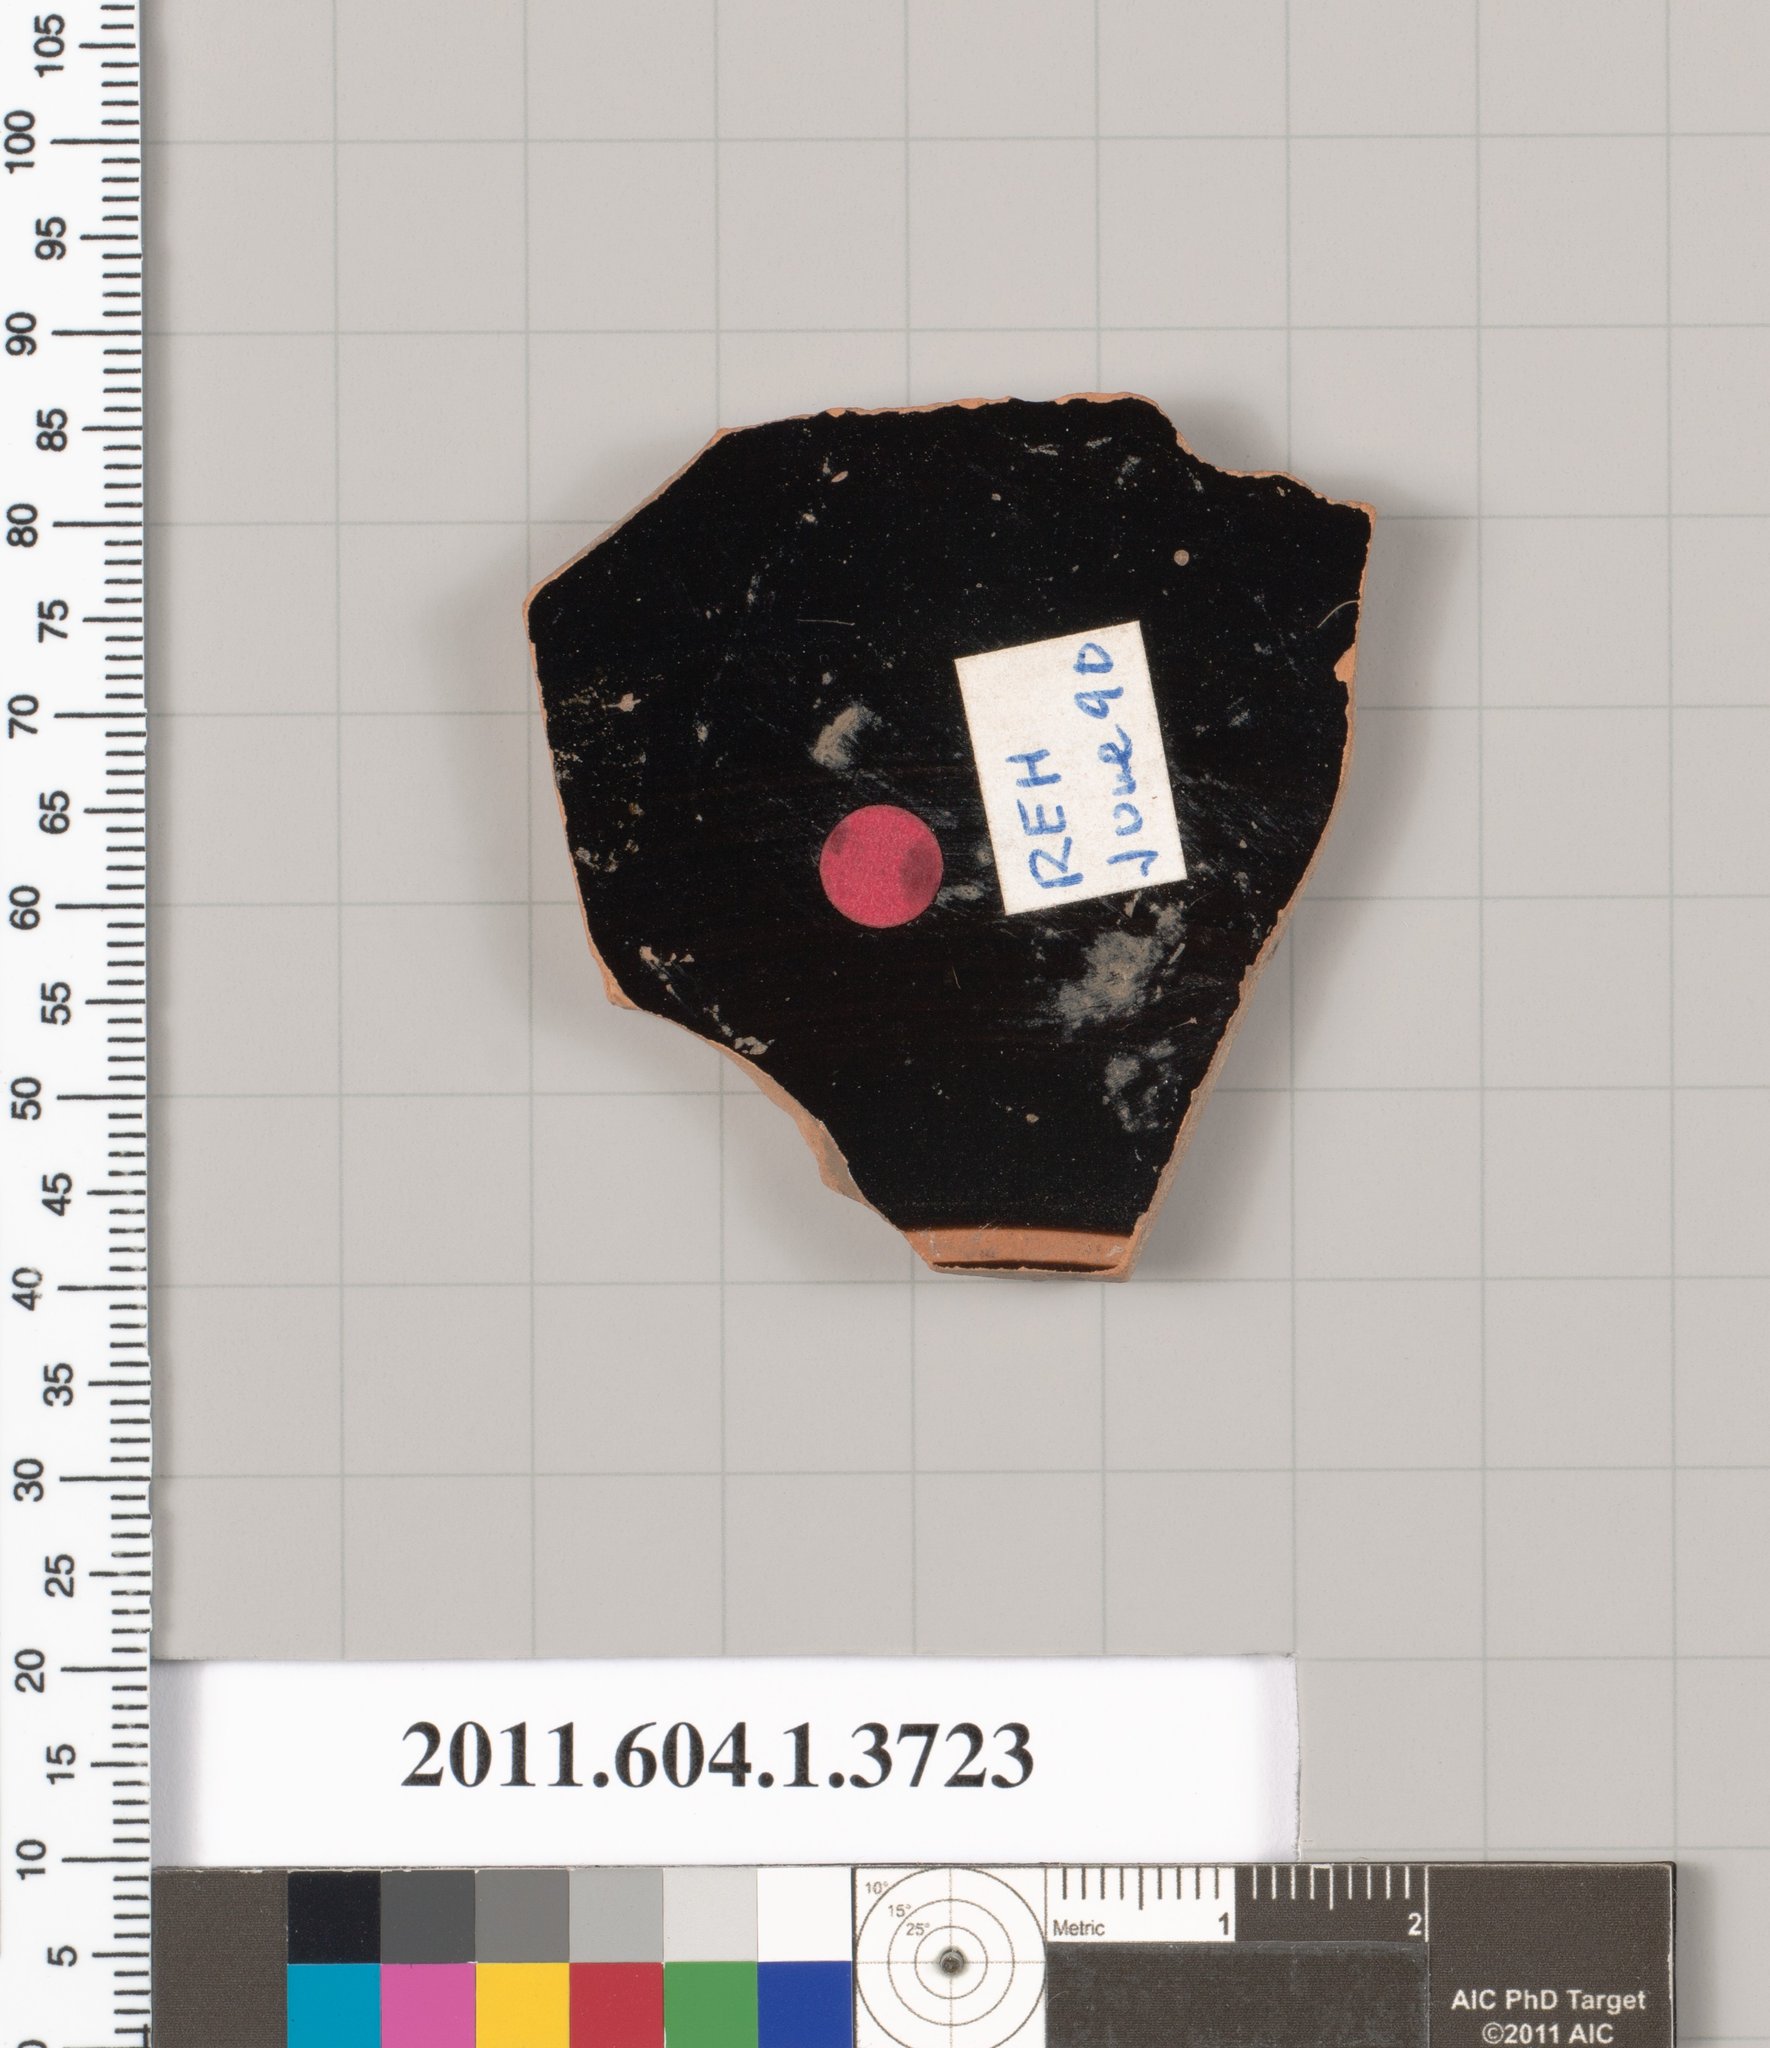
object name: kylix fragment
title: Terracotta fragment of a kylix (drinking cup)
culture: greek, attic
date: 475-451 BCE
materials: terracotta